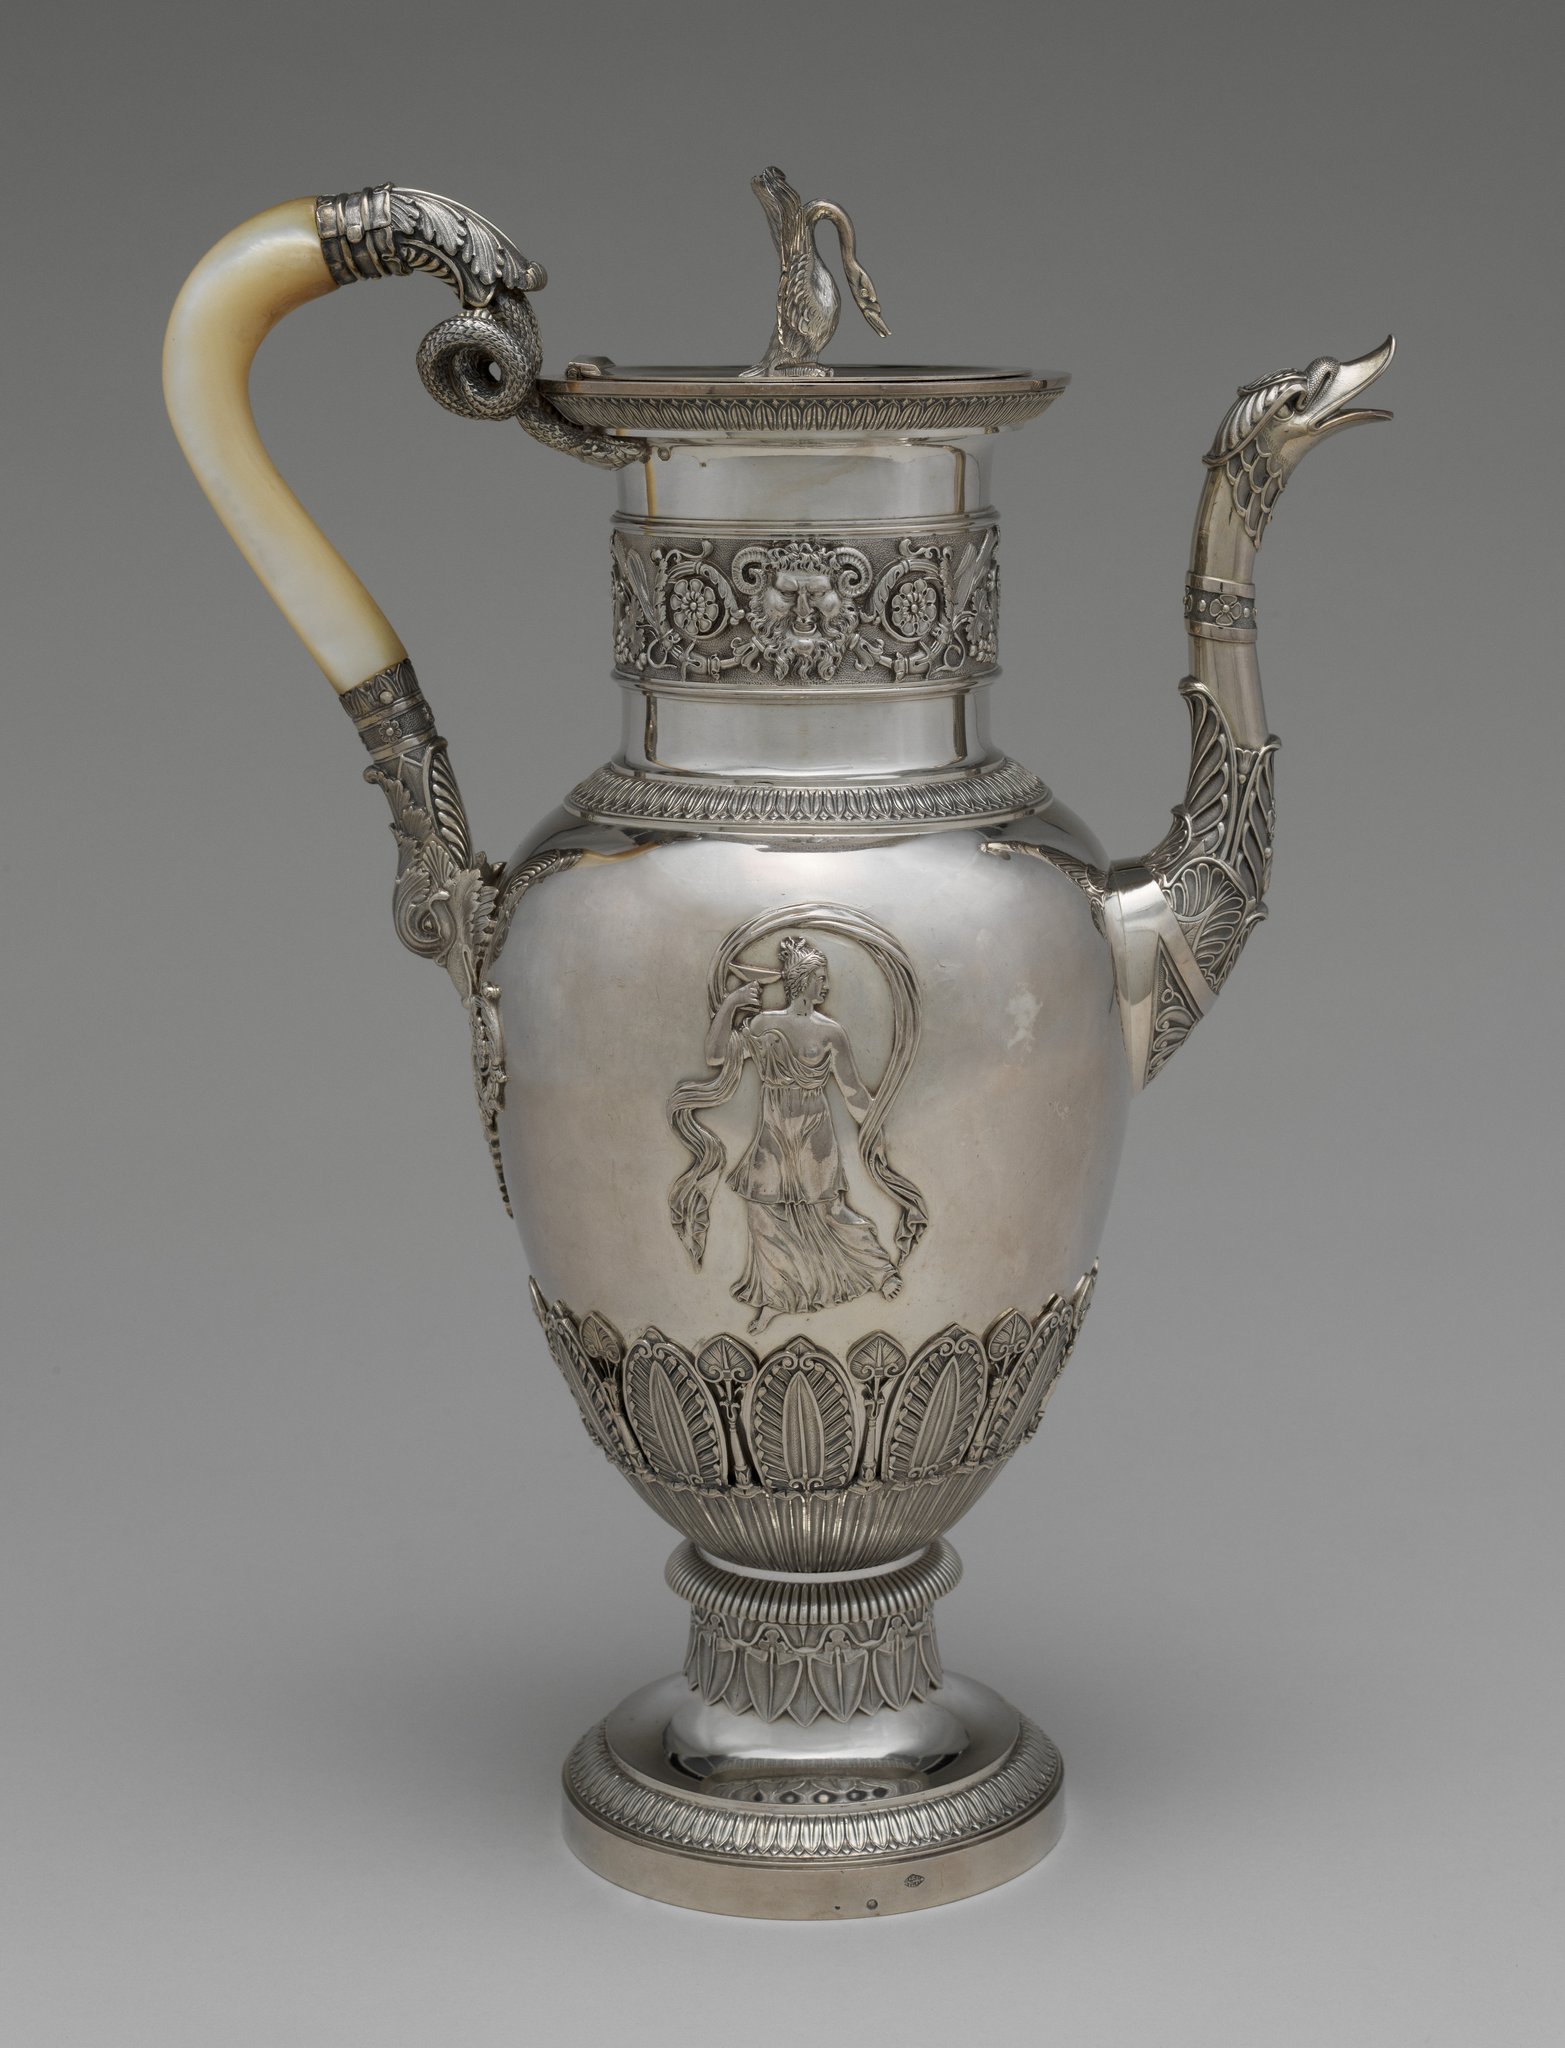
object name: coffeepot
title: Coffeepot (part of a service)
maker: marc jacquart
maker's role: maker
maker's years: 1767-1859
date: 1809-1819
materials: mother of pearl, silver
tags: birds,women